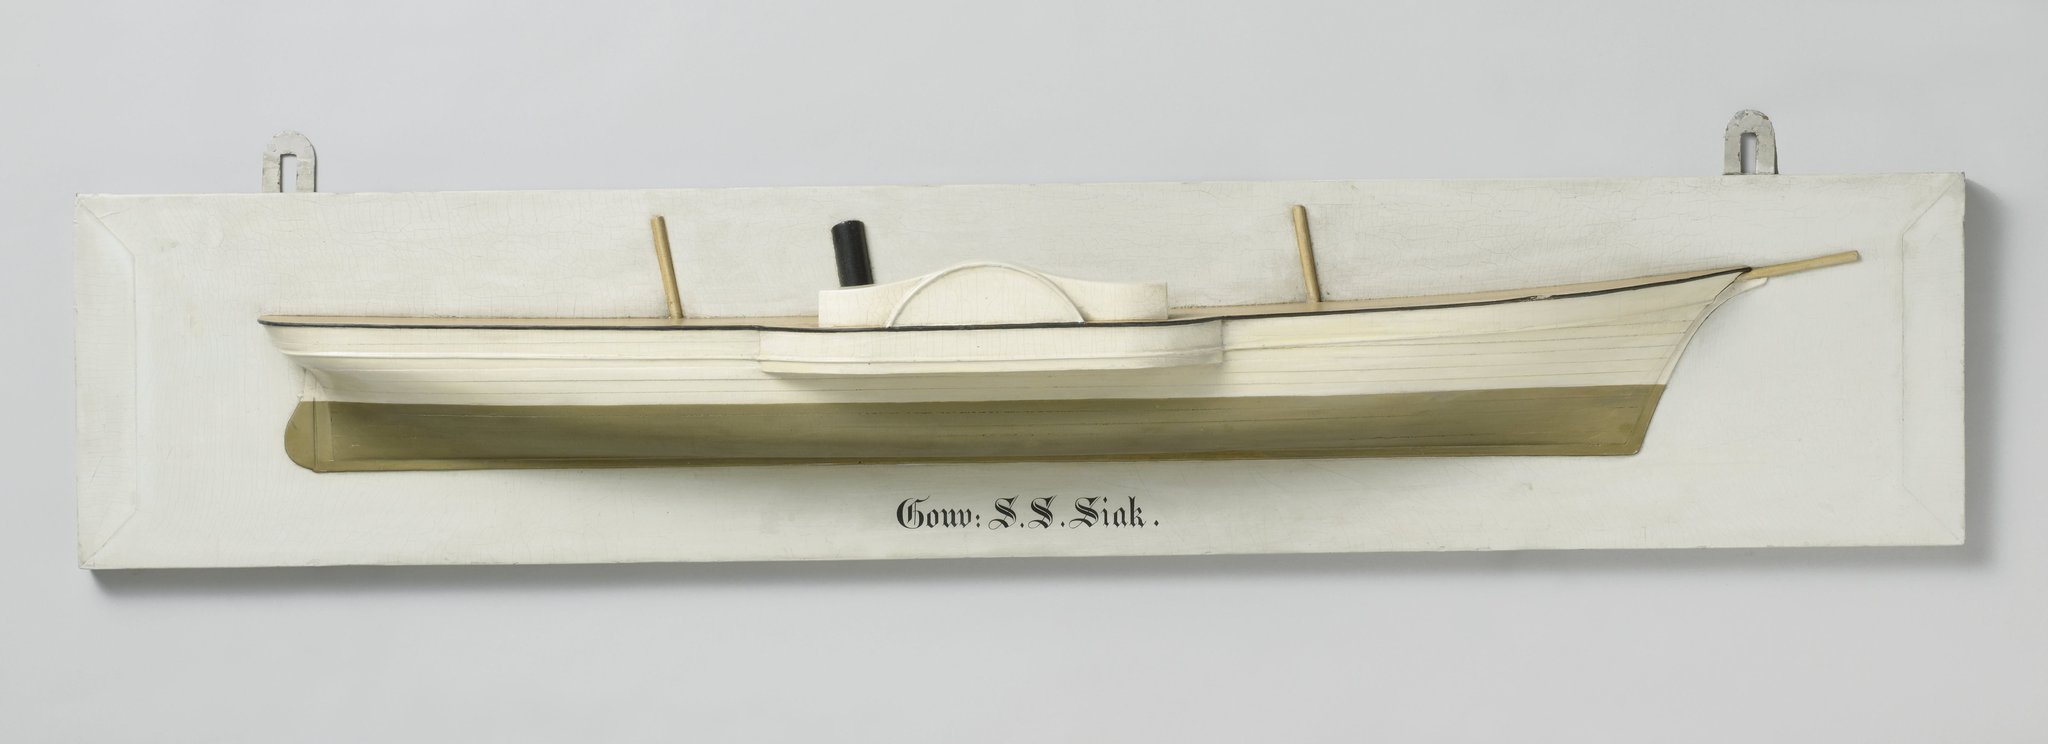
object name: ship model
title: Half model of the paddle steamer <Siak>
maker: Anonymous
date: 1874-1877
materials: wood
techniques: polychromy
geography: surabaya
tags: siak (schip)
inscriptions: inscription, bottom centre, in a Gothic hand: ‘Gouv: S.S. Siak’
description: Gepolychromeerd stapelmodel (stuurboord) van een tweemast raderstoomschip. Het model heeft een klippersteven. Elliptisch hek met roer met ronde roerkoning (Amerikaans roer) en afgerond blad. Eén gesloten raderkast in de zijde, een schoorsteen aan dek. De zeeg loopt naar voren op; het onderwaterschip is een rondspant met vlakke bodem.